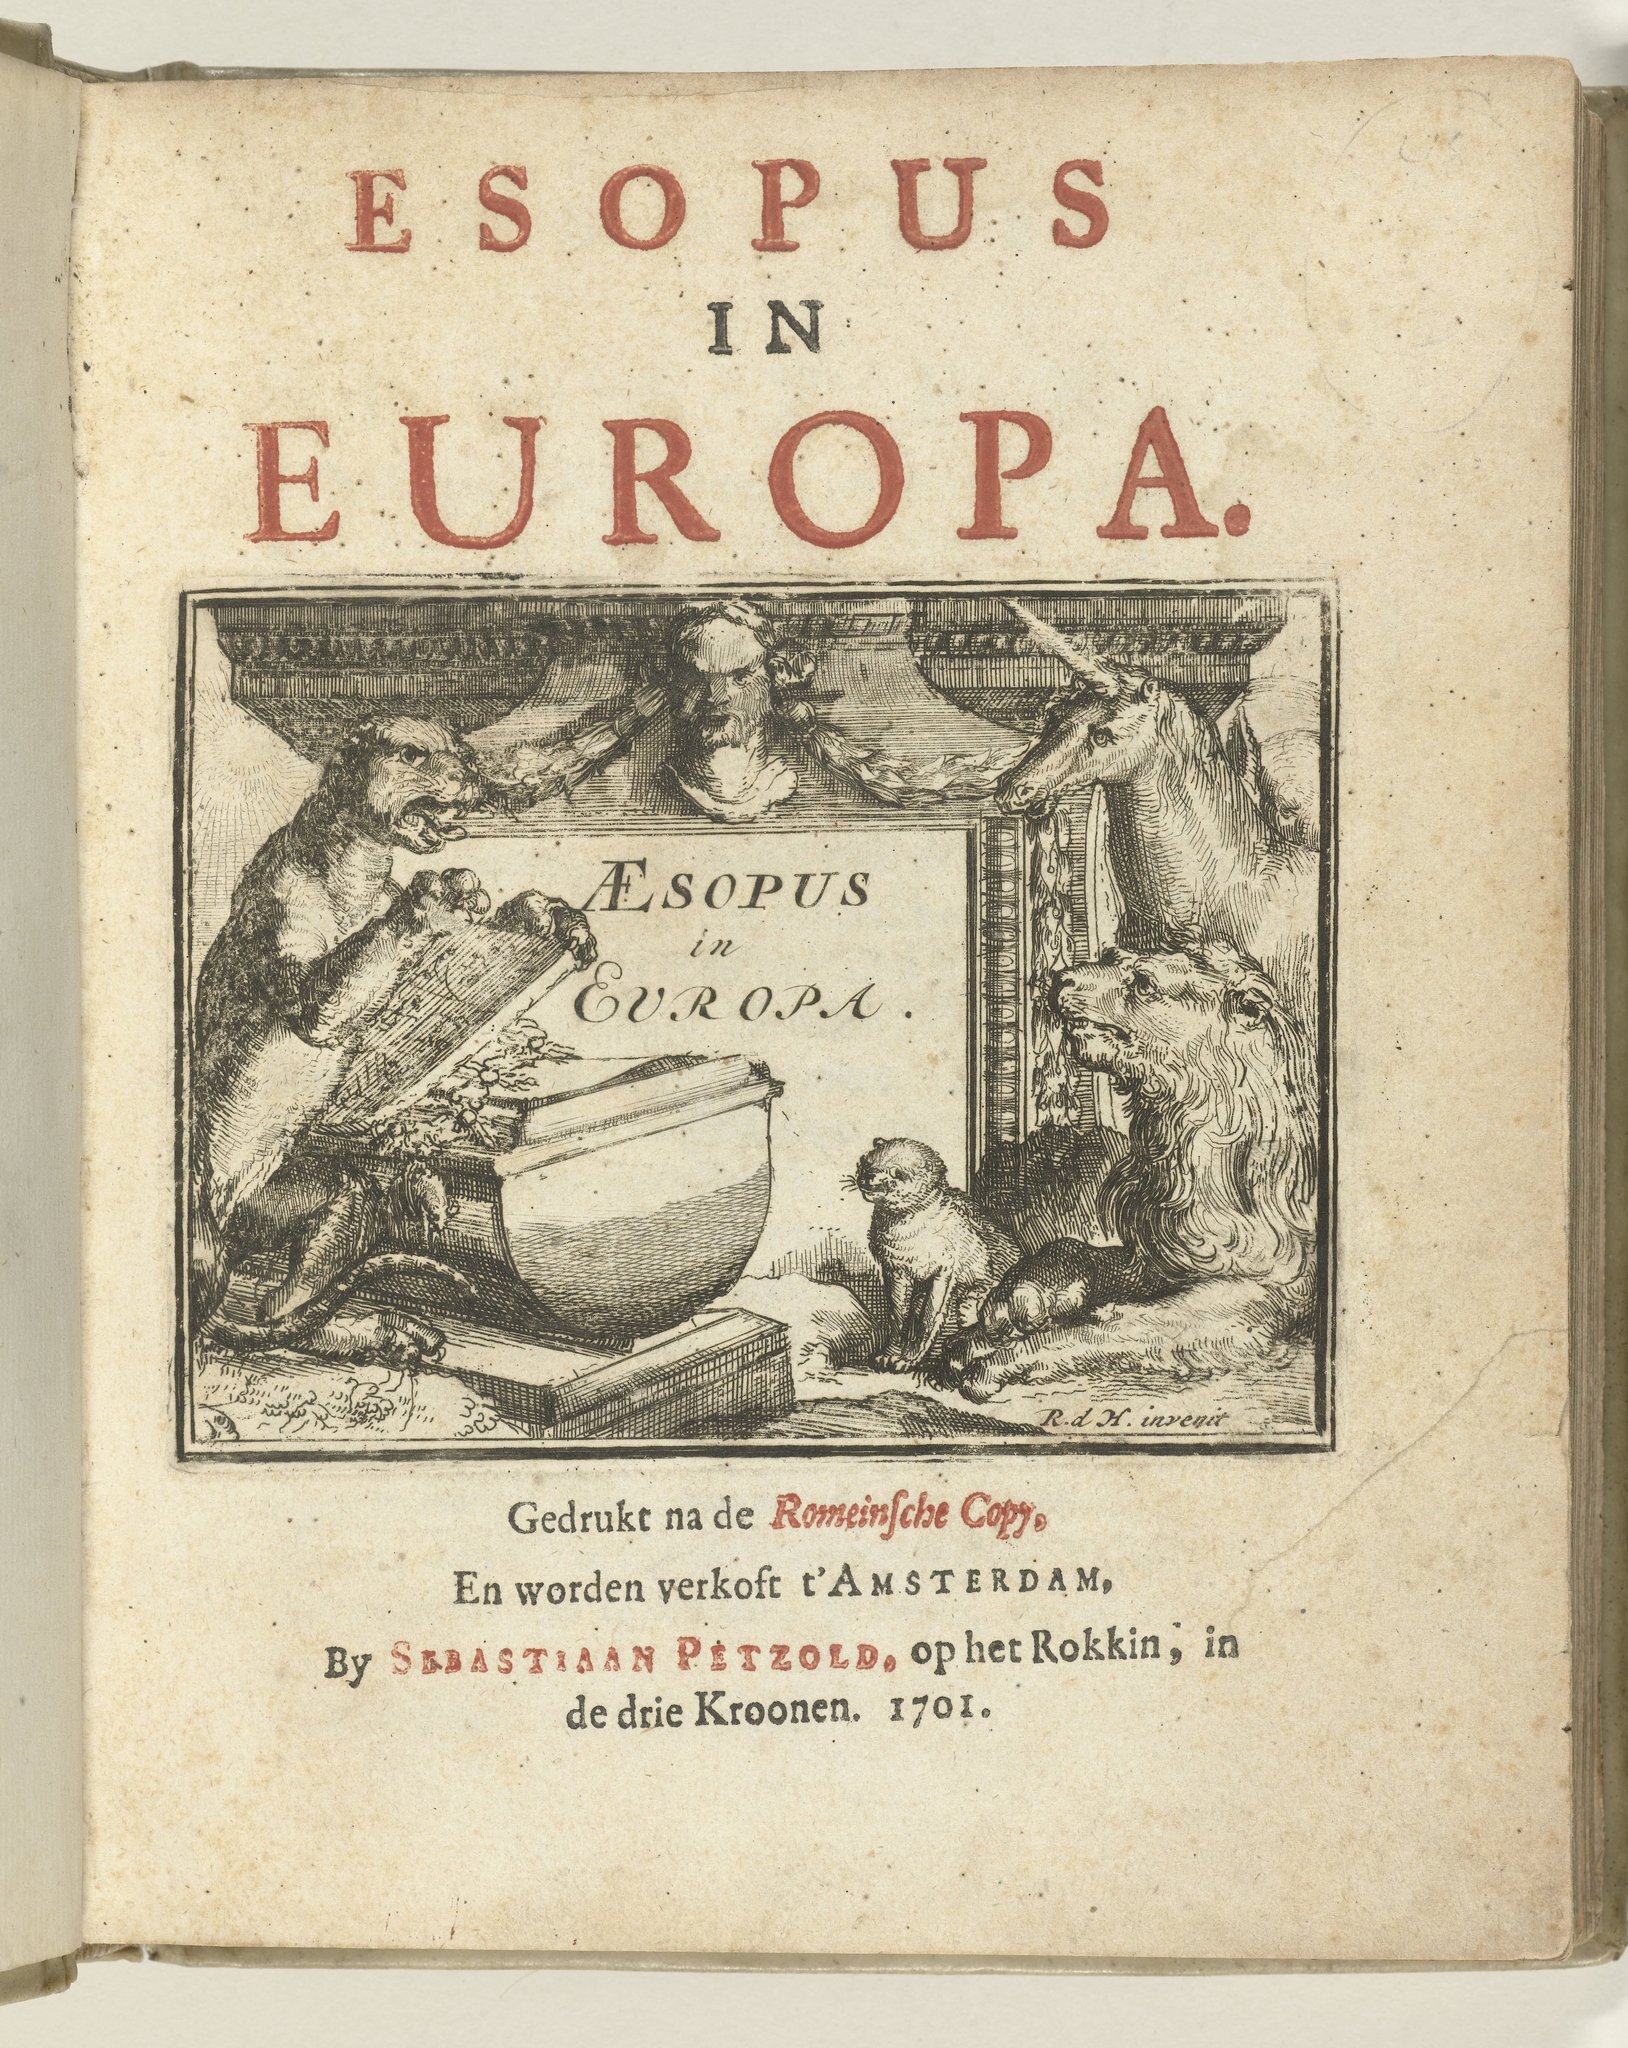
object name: print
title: Aesopus in Europa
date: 1701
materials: paper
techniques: etching, letterpress printing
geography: netherlands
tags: spaanse successieoorlog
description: Titelblad voor het eerste pamflet in de bundel van pamfletten getiteld: Esopus in Europa. De tijger (Frankrijk) met het wapen van Spanje tussen de poten bij het grafkist van Karel II van Spanje. Rechts zien een eenhoorn (Engeland), leeuw (Holland) en een kat (Zuidelijke Nederlanden) toe.